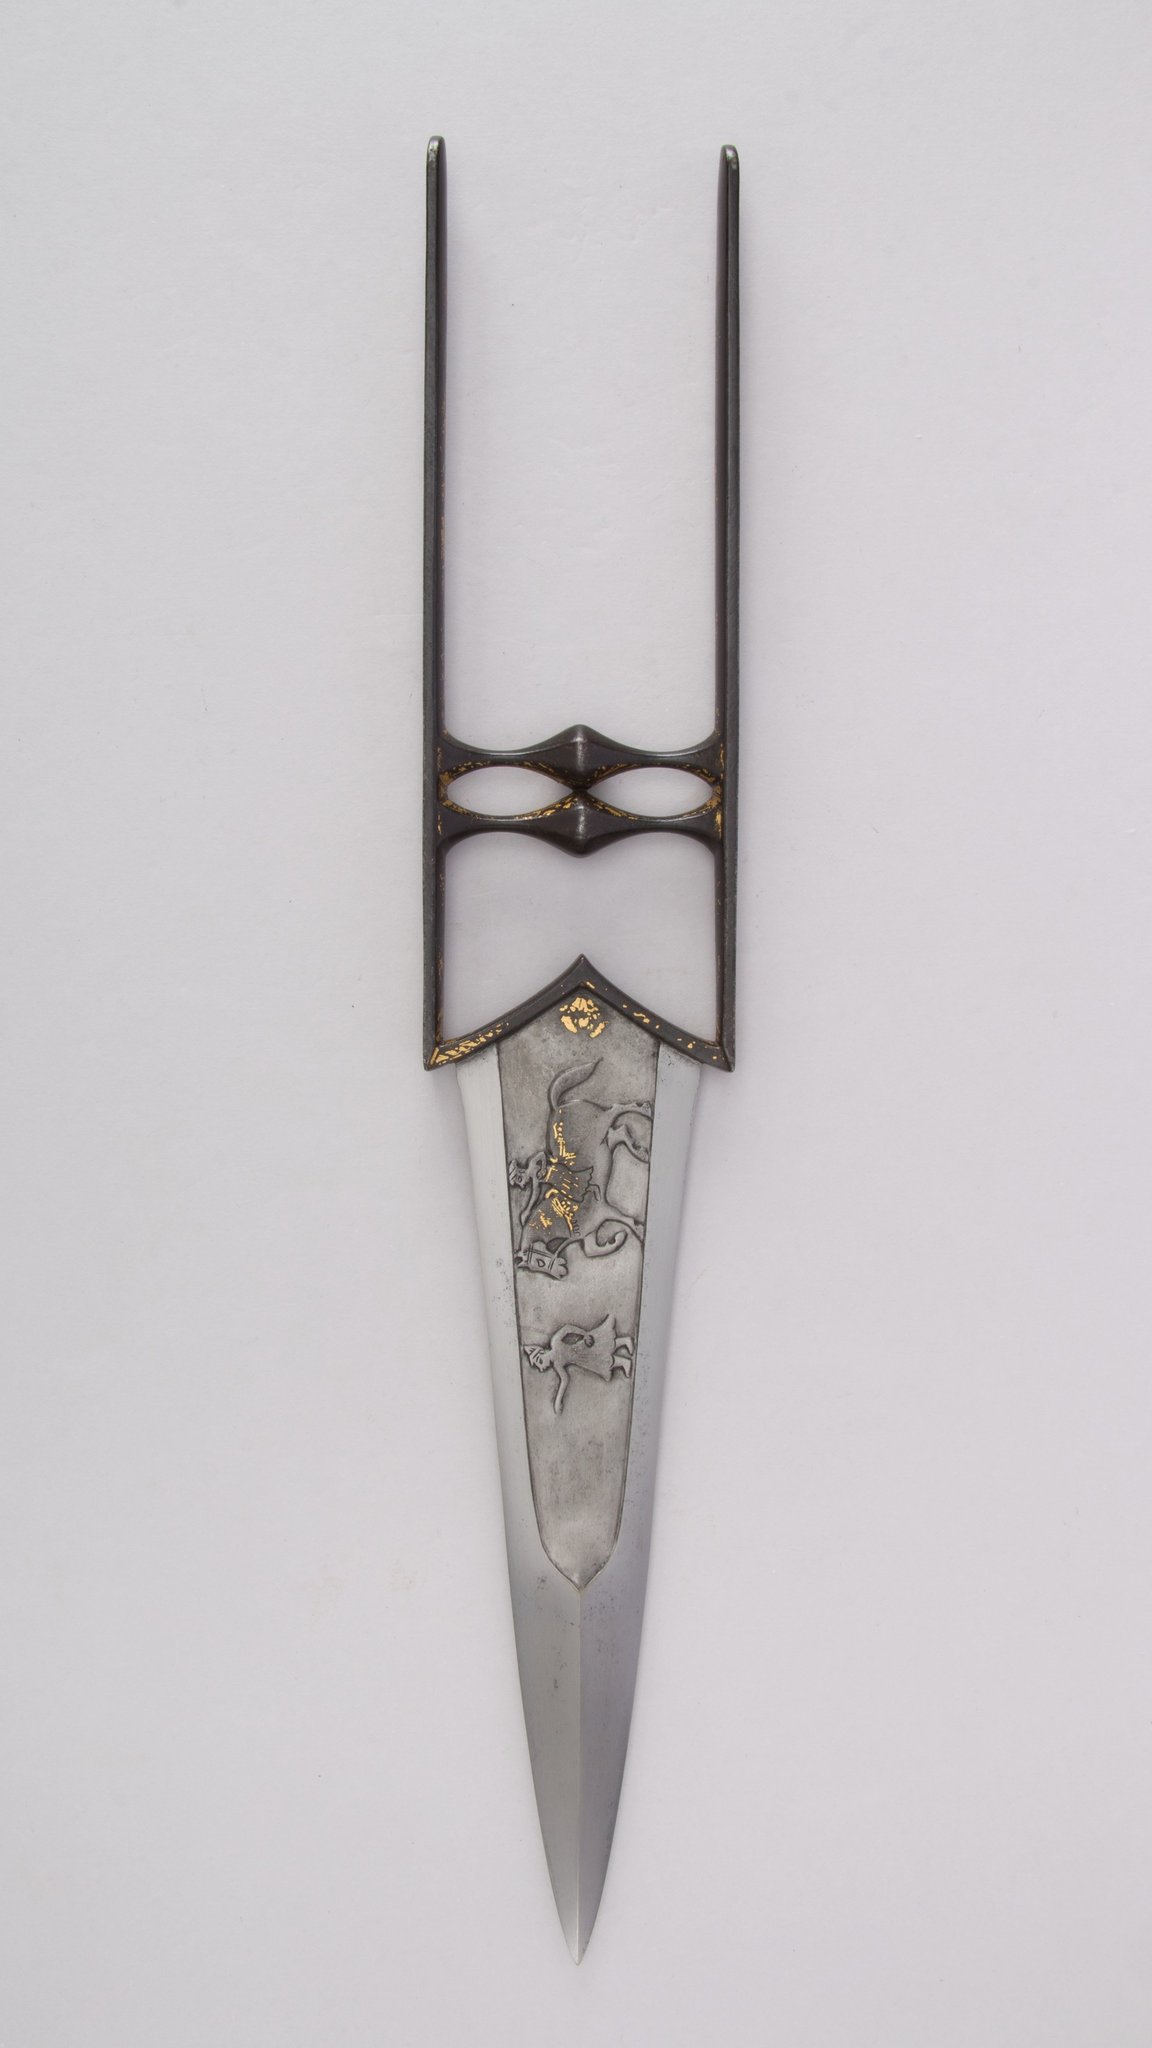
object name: dagger katar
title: Dagger (Katar)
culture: indian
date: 1701-1800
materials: gold, steel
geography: north india